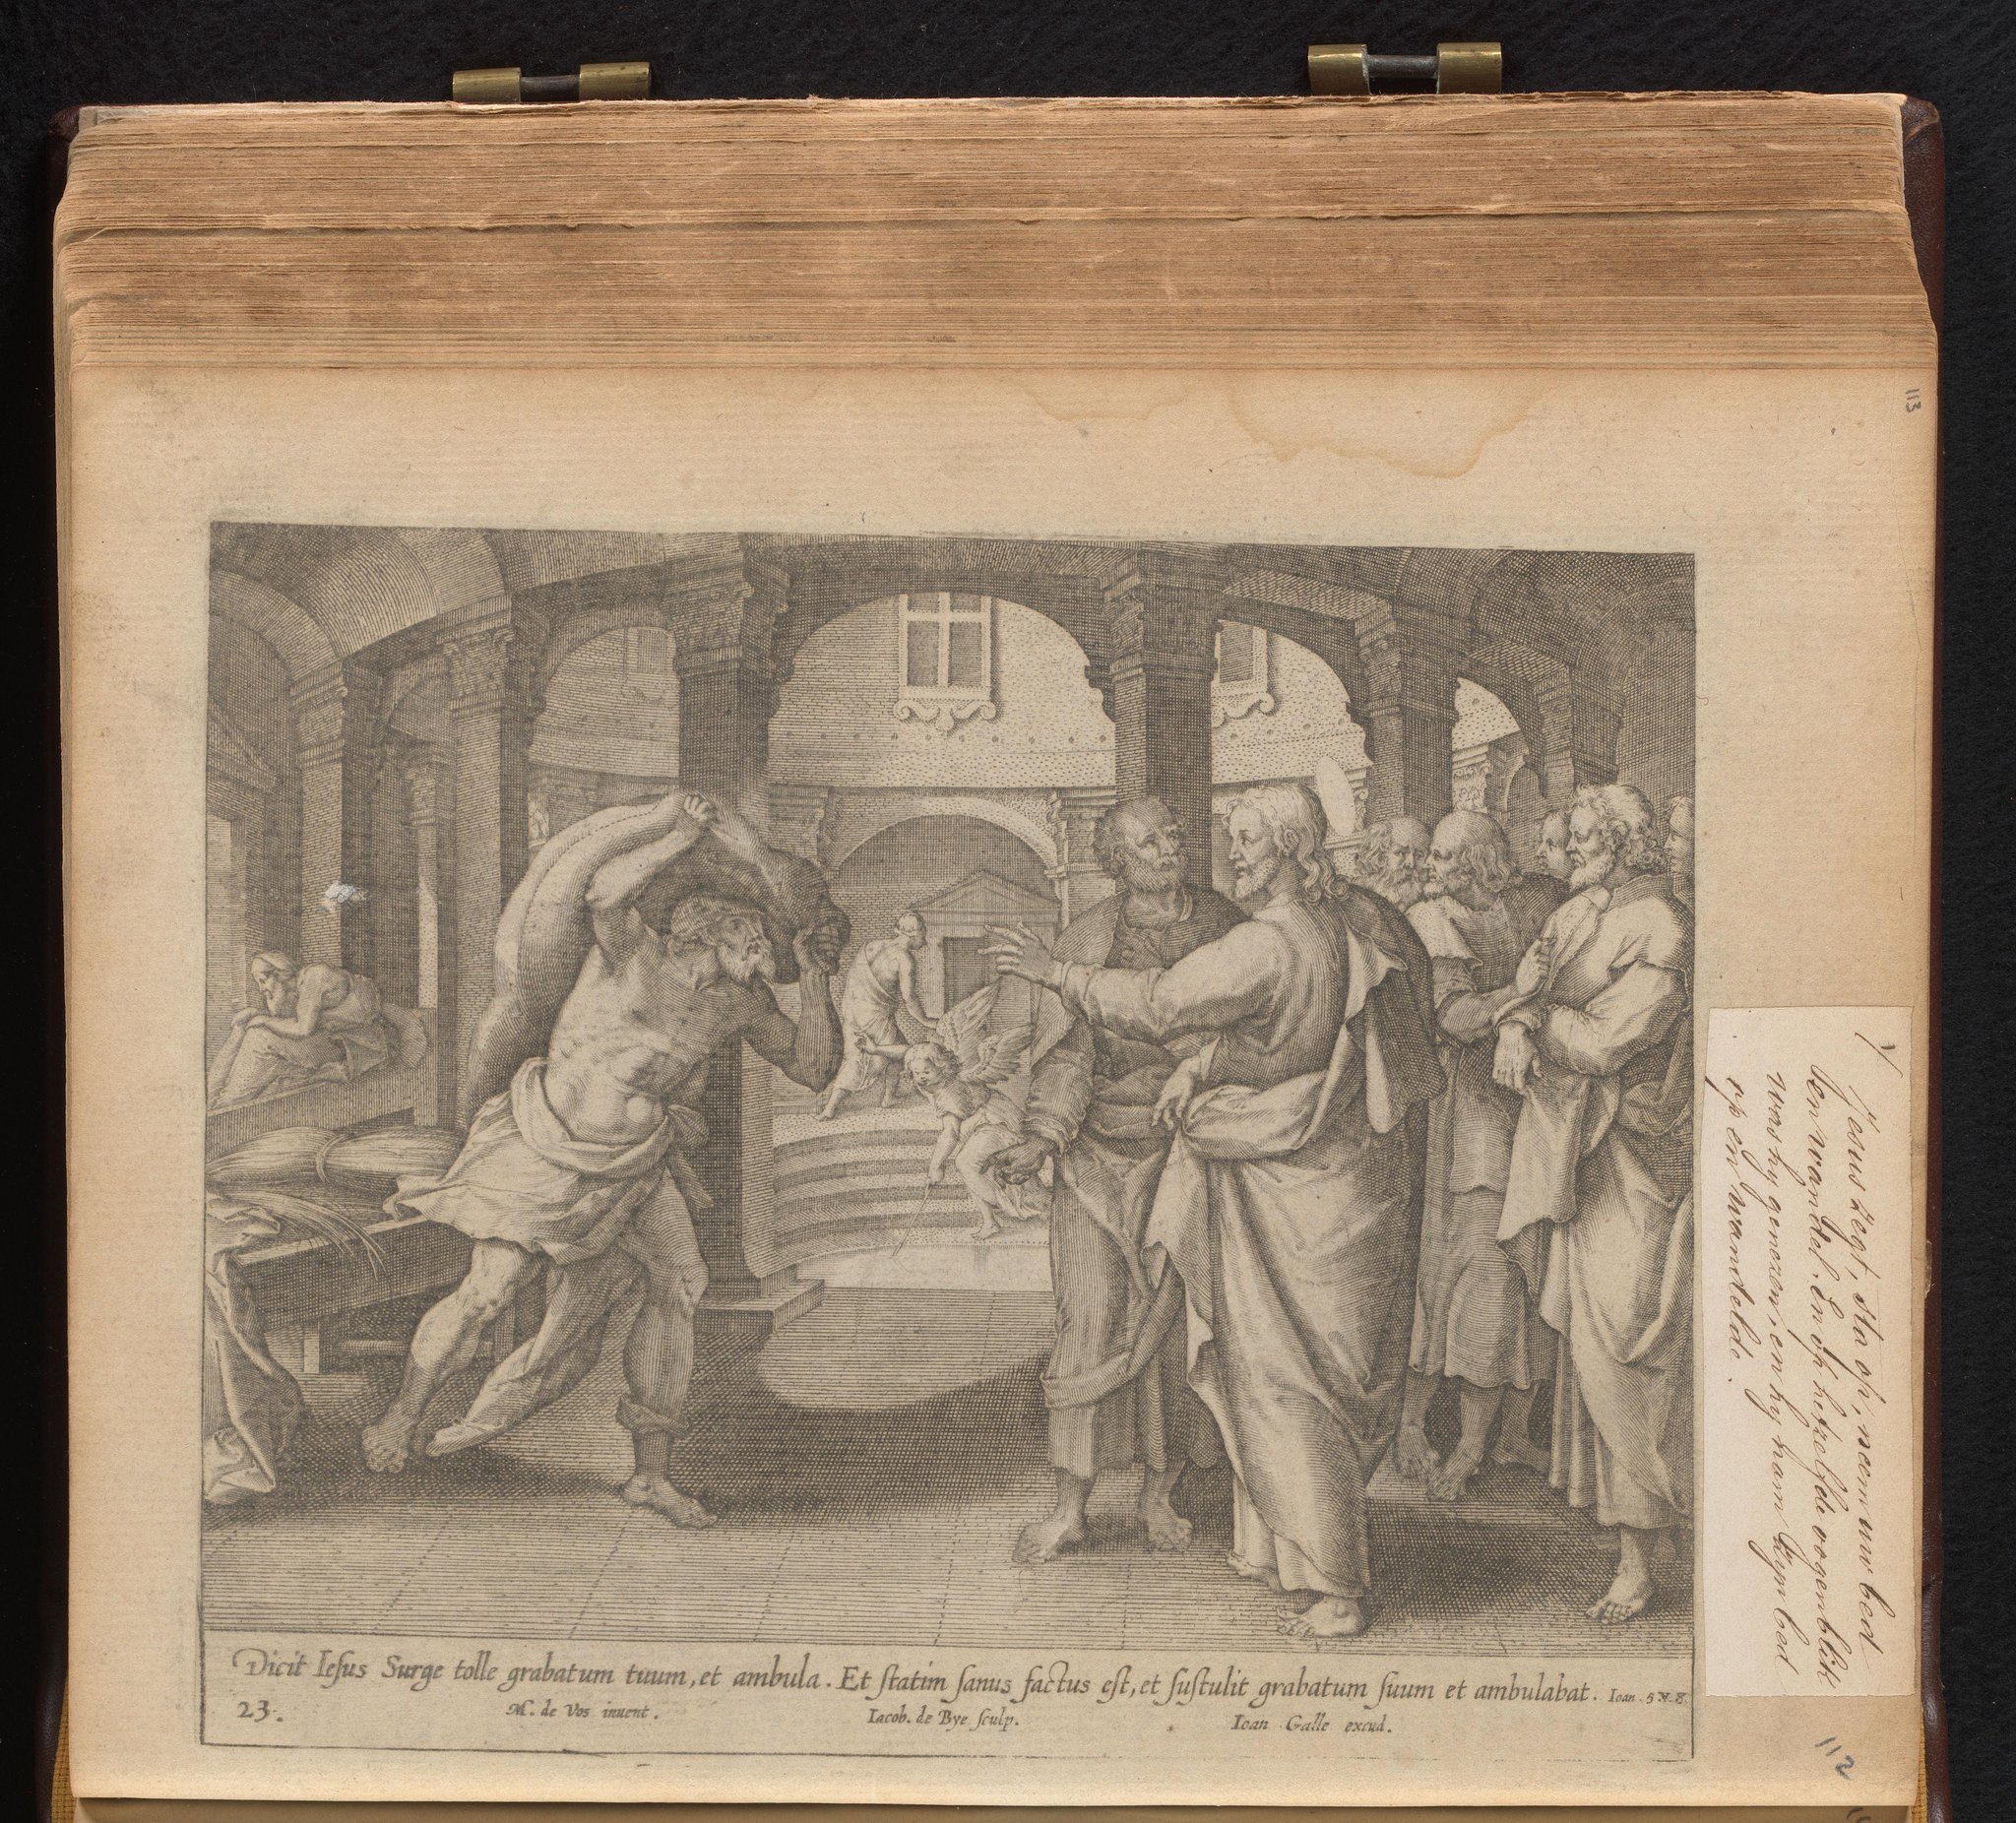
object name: print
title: Vita, passio et Resvrrectio Iesv Christi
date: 1598-1618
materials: paper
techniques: engraving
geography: antwerp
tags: christ says to a paralytic man: 'rise, take up your pallet (bed)', an angel stirs up the water of the pool of bethesda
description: Prent maakt deel uit van een prentbijbel.